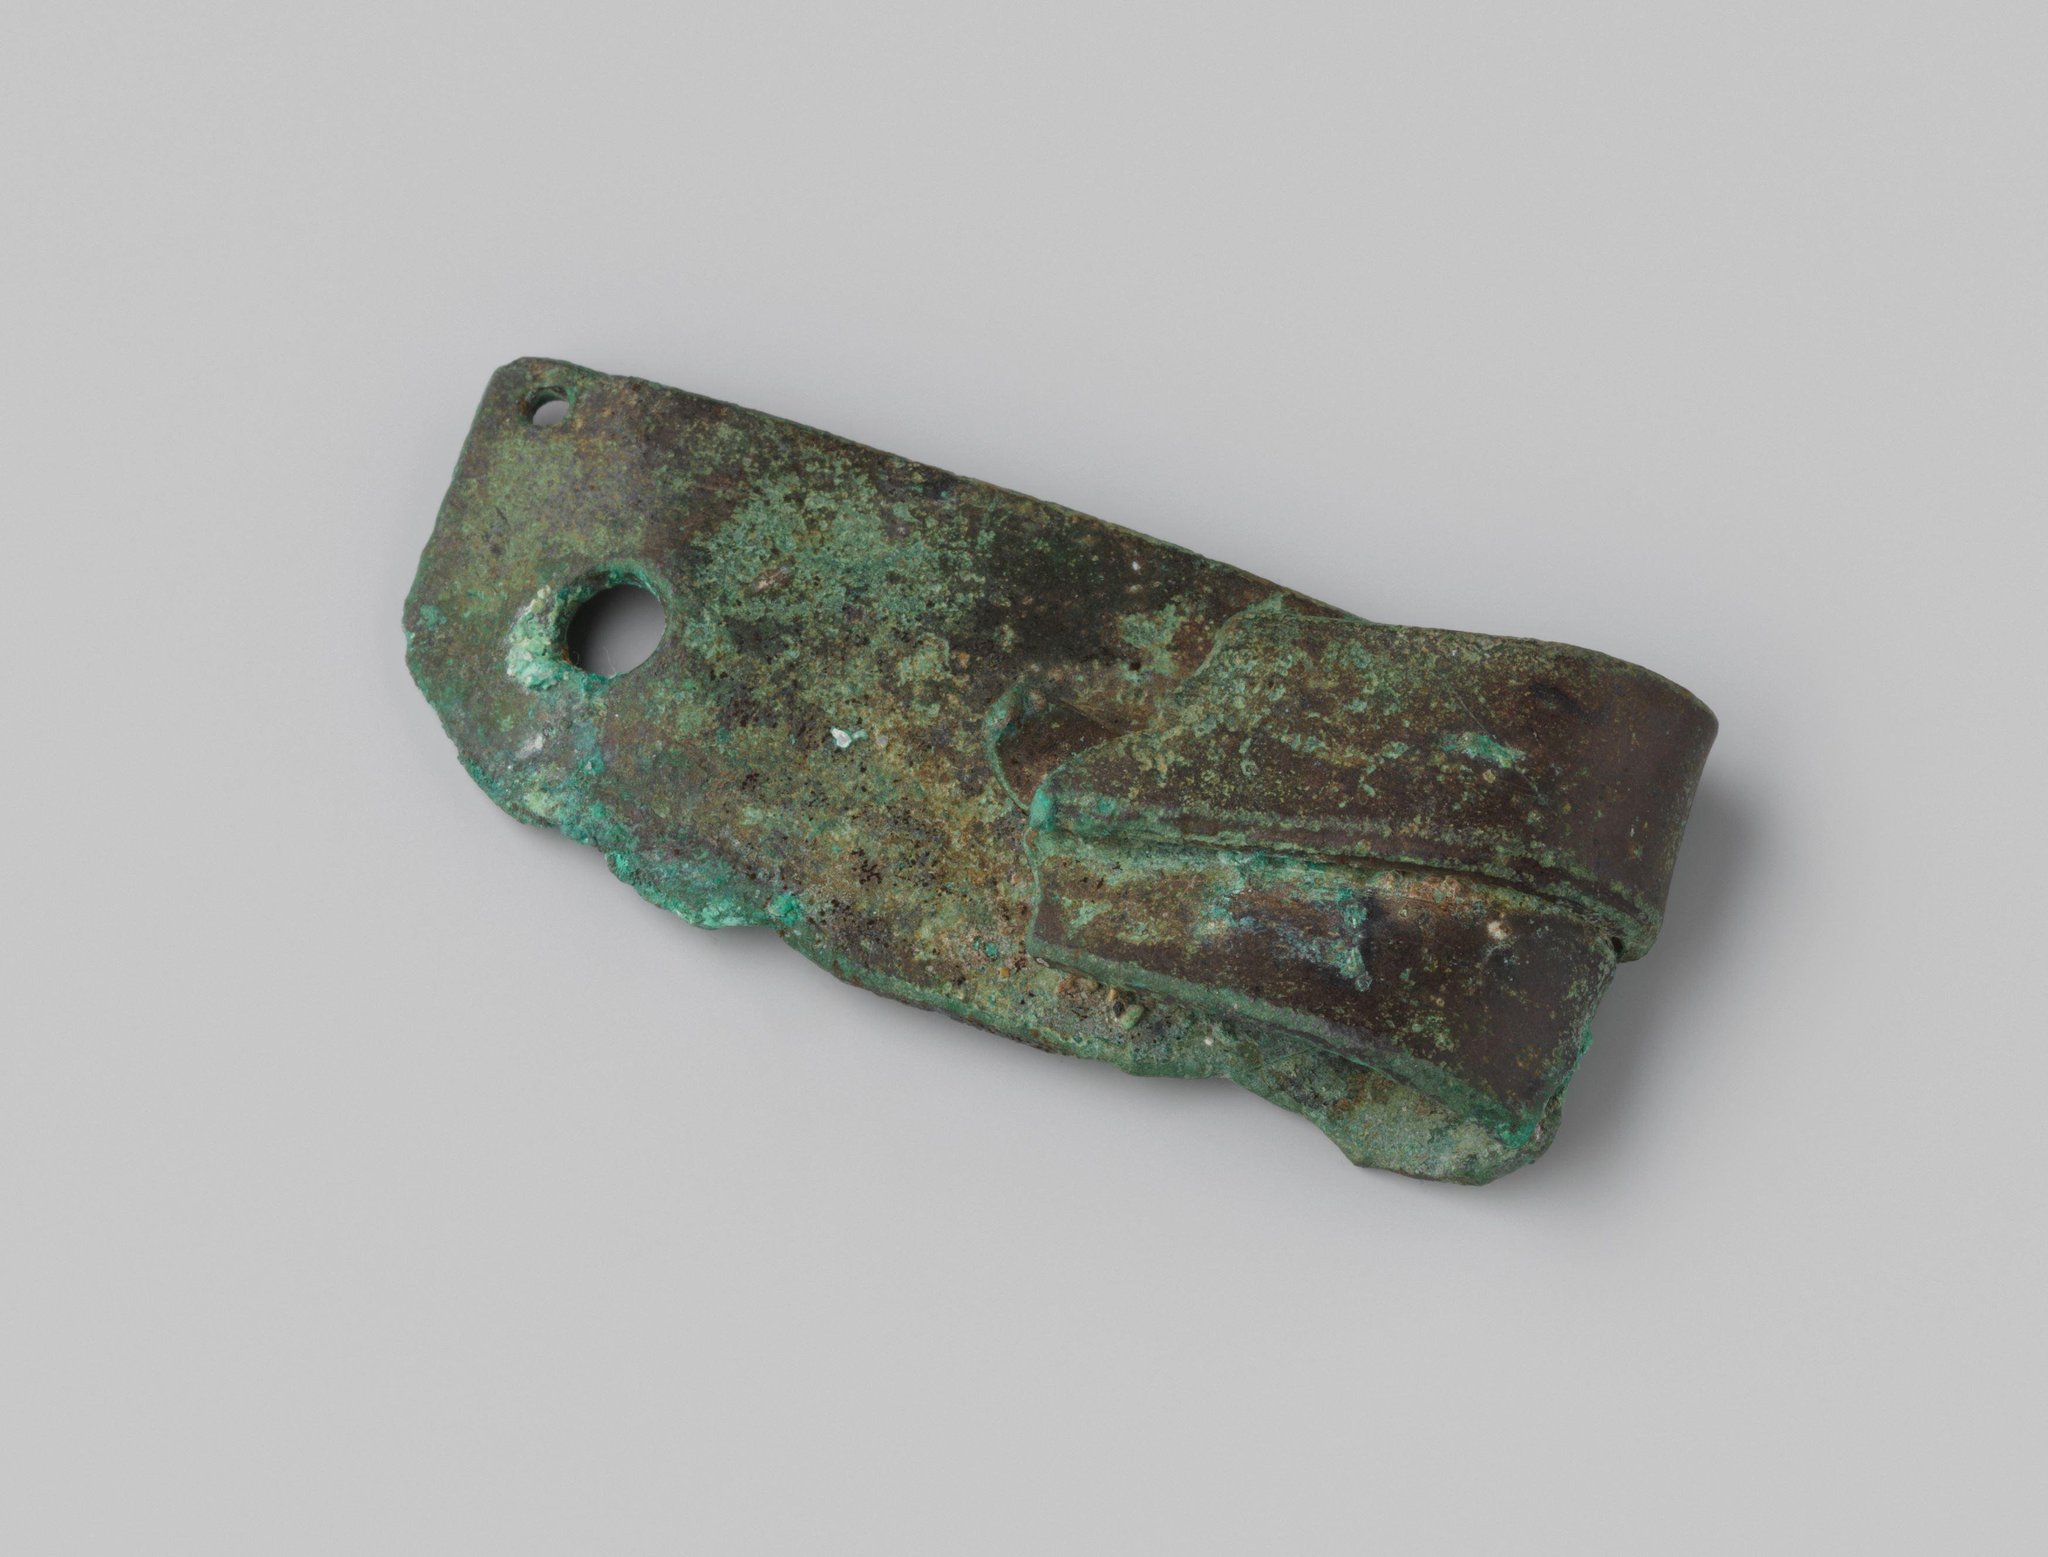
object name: hasp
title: Beugel uit het wrak van de Oost-Indiëvaarder Hollandia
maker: Anonymous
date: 1700-1743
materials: copper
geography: netherlands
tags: verenigde oostindische compagnie, hollandia (schip), annet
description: Locks, fastenings and accessories, hasp; fragm, broken, squashed, id. NG 1979-220H2132.